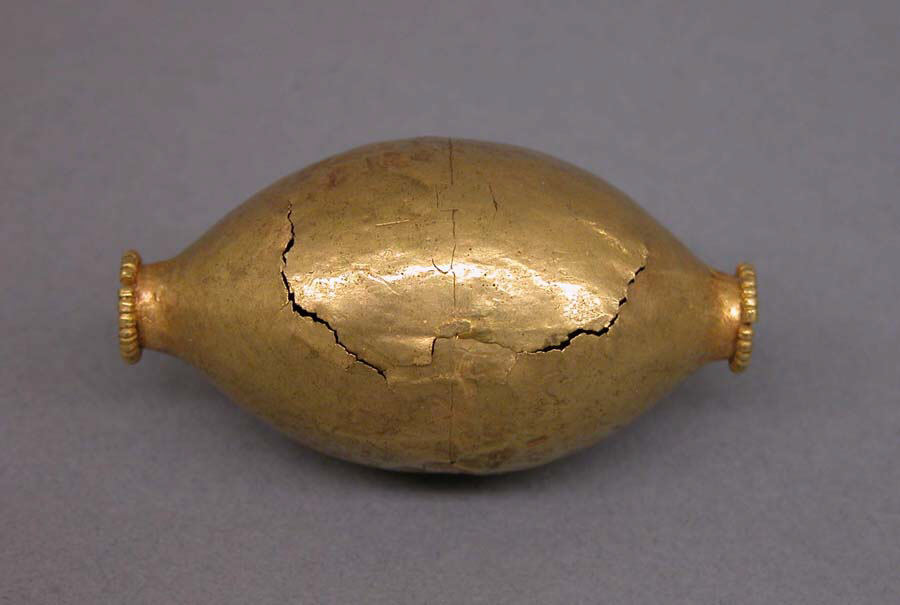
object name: bead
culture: indonesian, javanese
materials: gold